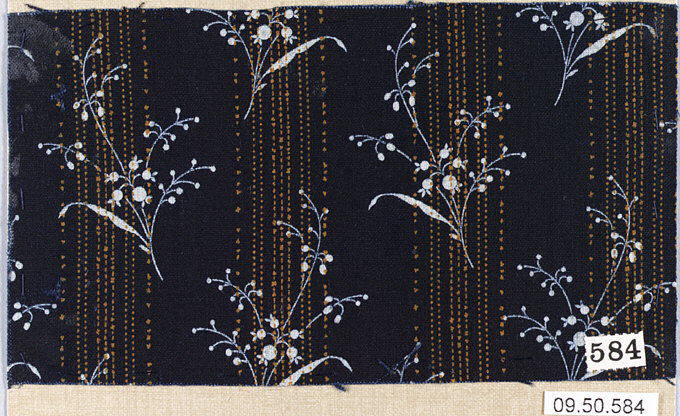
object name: piece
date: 1801-1900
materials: cotton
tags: flowers,leaves